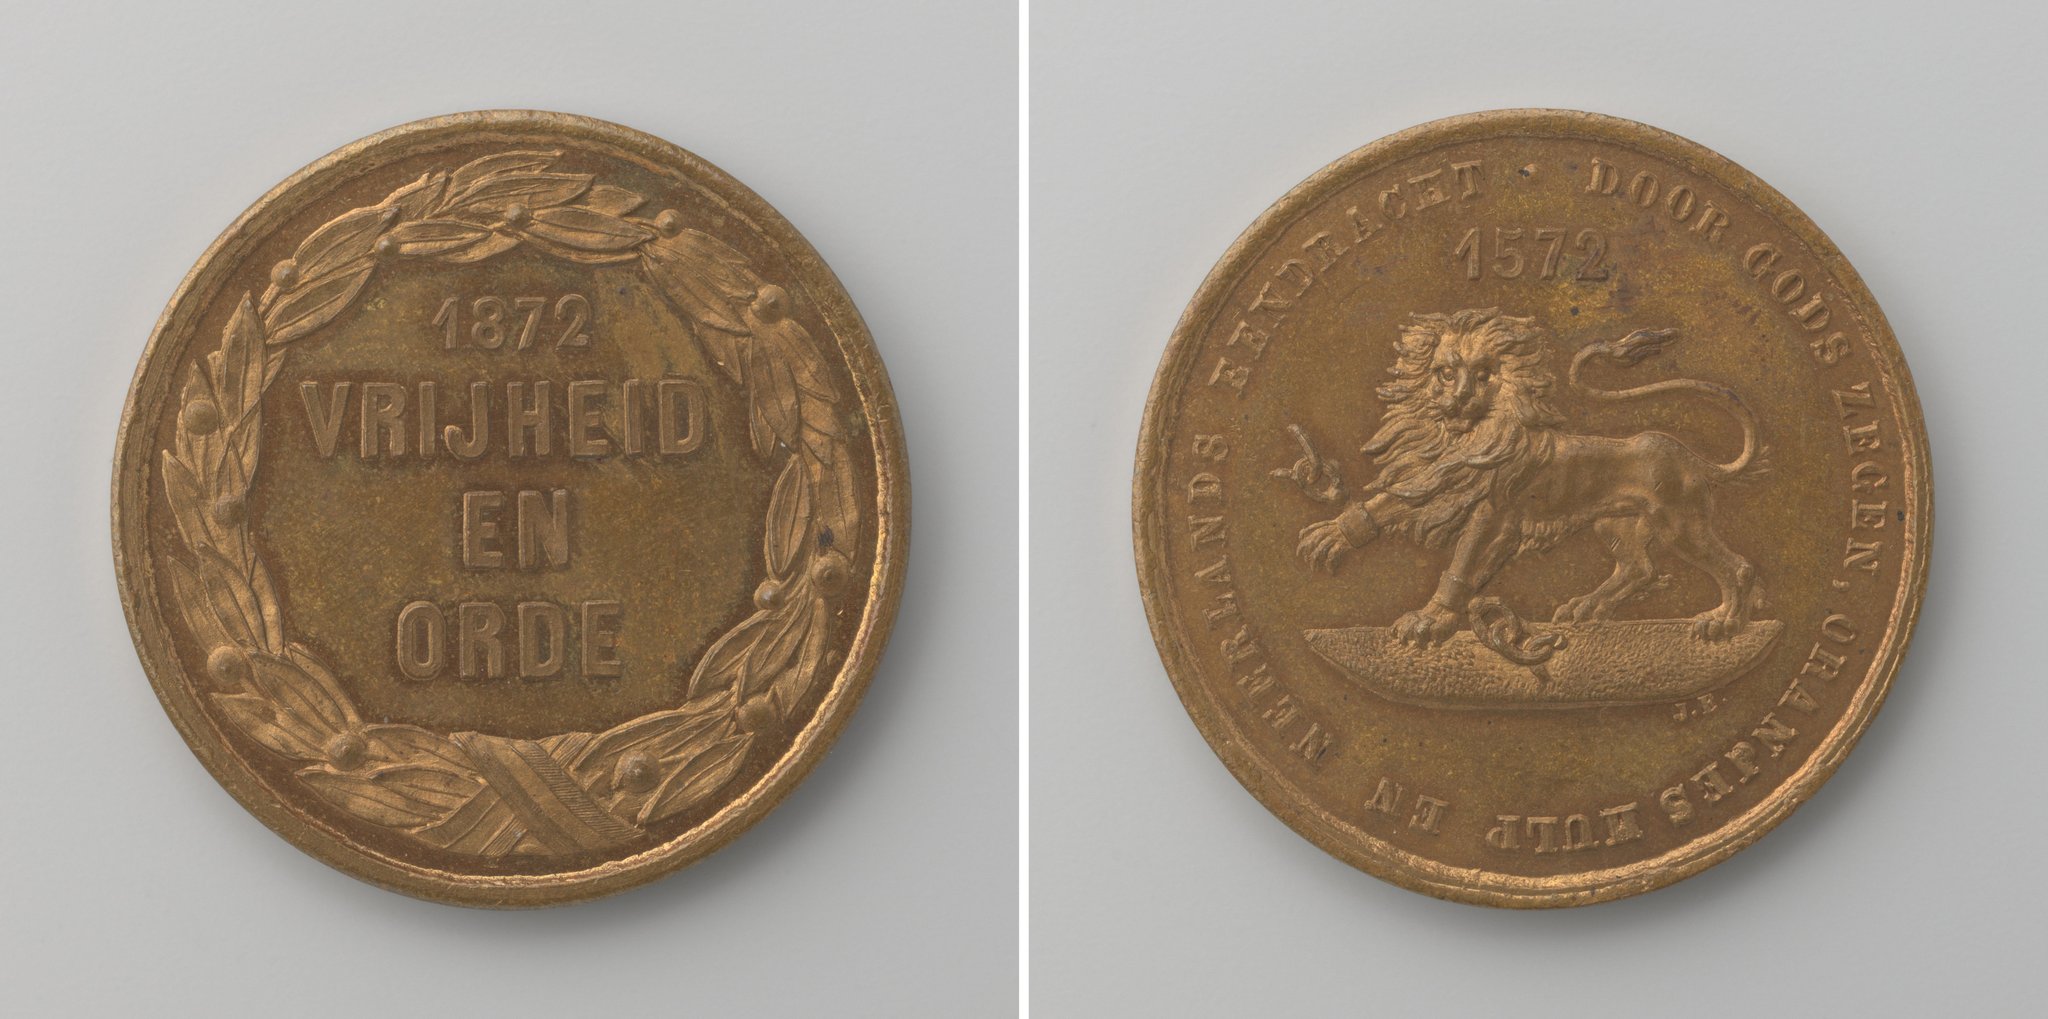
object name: history medal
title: Herdenking van de inname van Den Briel 1872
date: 1872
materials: brass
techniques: striking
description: Messing penning, op de voorzijde de Nederlandse Leeuw met verbroken kluisters onder het jaartal 1572, met omschrift, op de keerzijde vier regels tekst in een lauwerkrans.